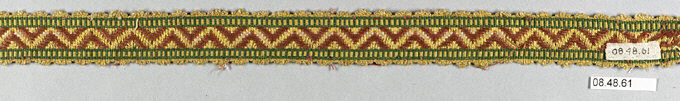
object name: galloon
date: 1801-1833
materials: silk